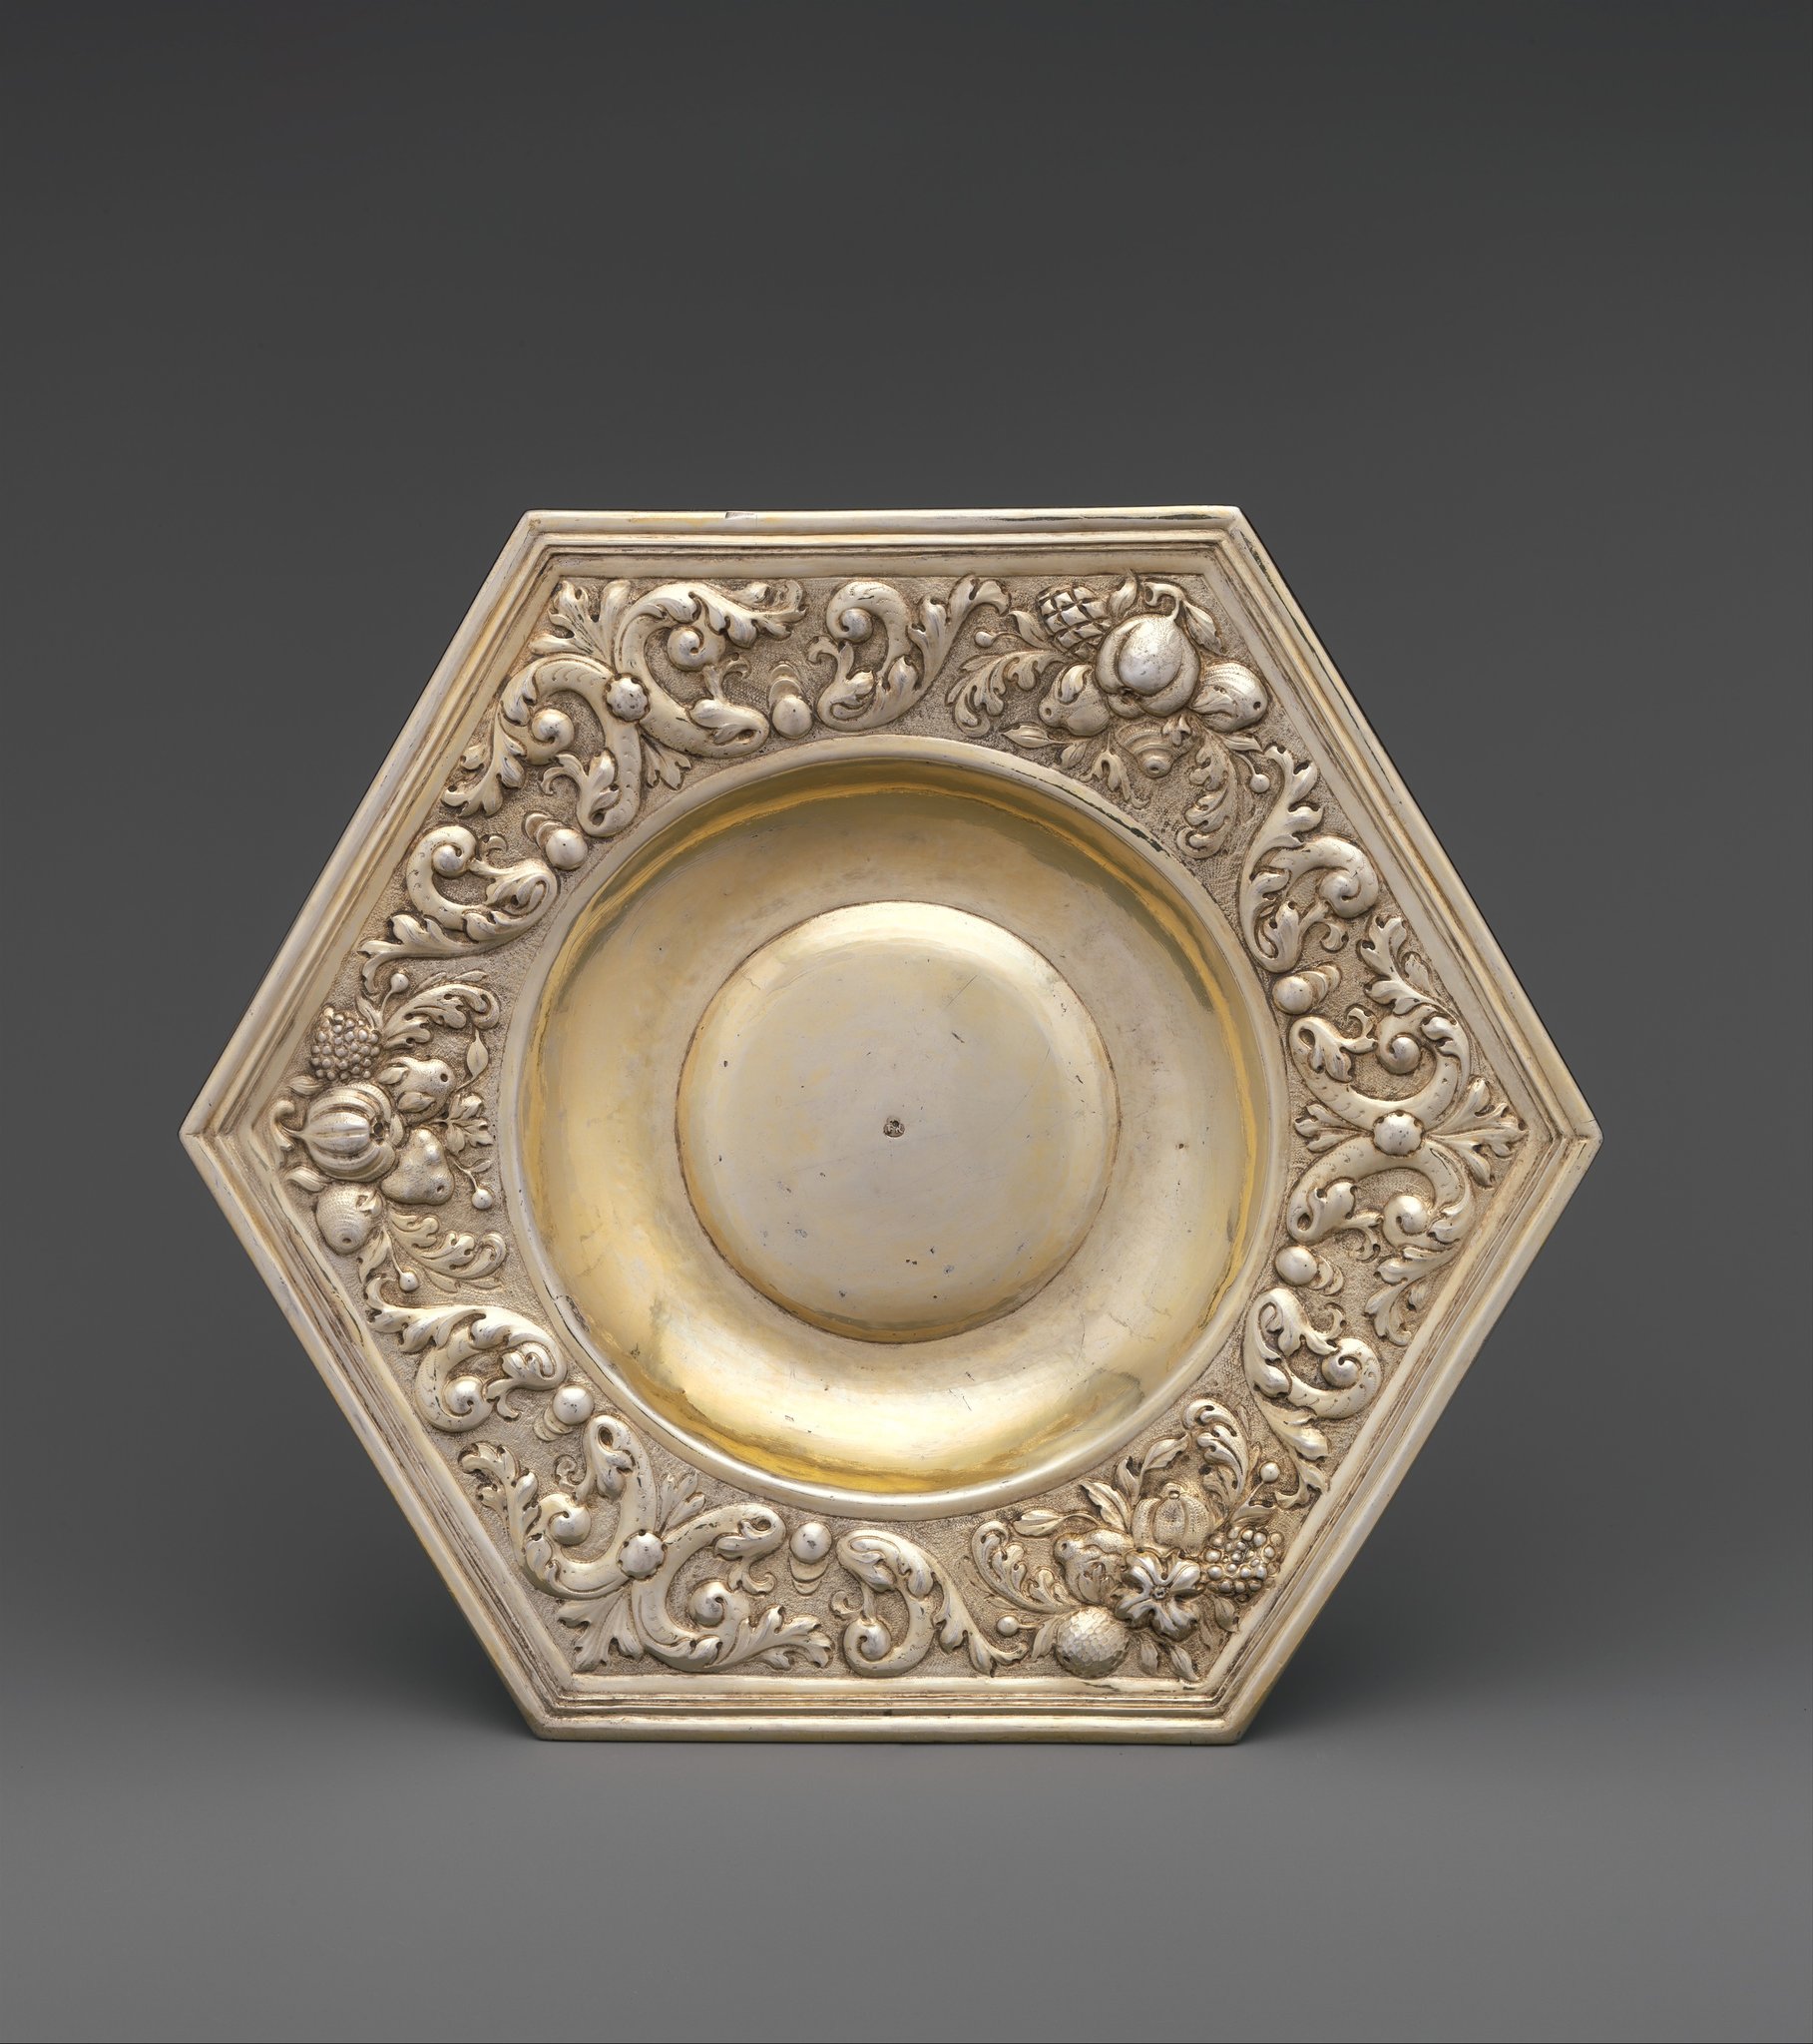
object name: dish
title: Hexagonal dish (part of a set)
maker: paulus roth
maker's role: maker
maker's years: 1589-1689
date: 1651-1700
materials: gilt silver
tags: fruit